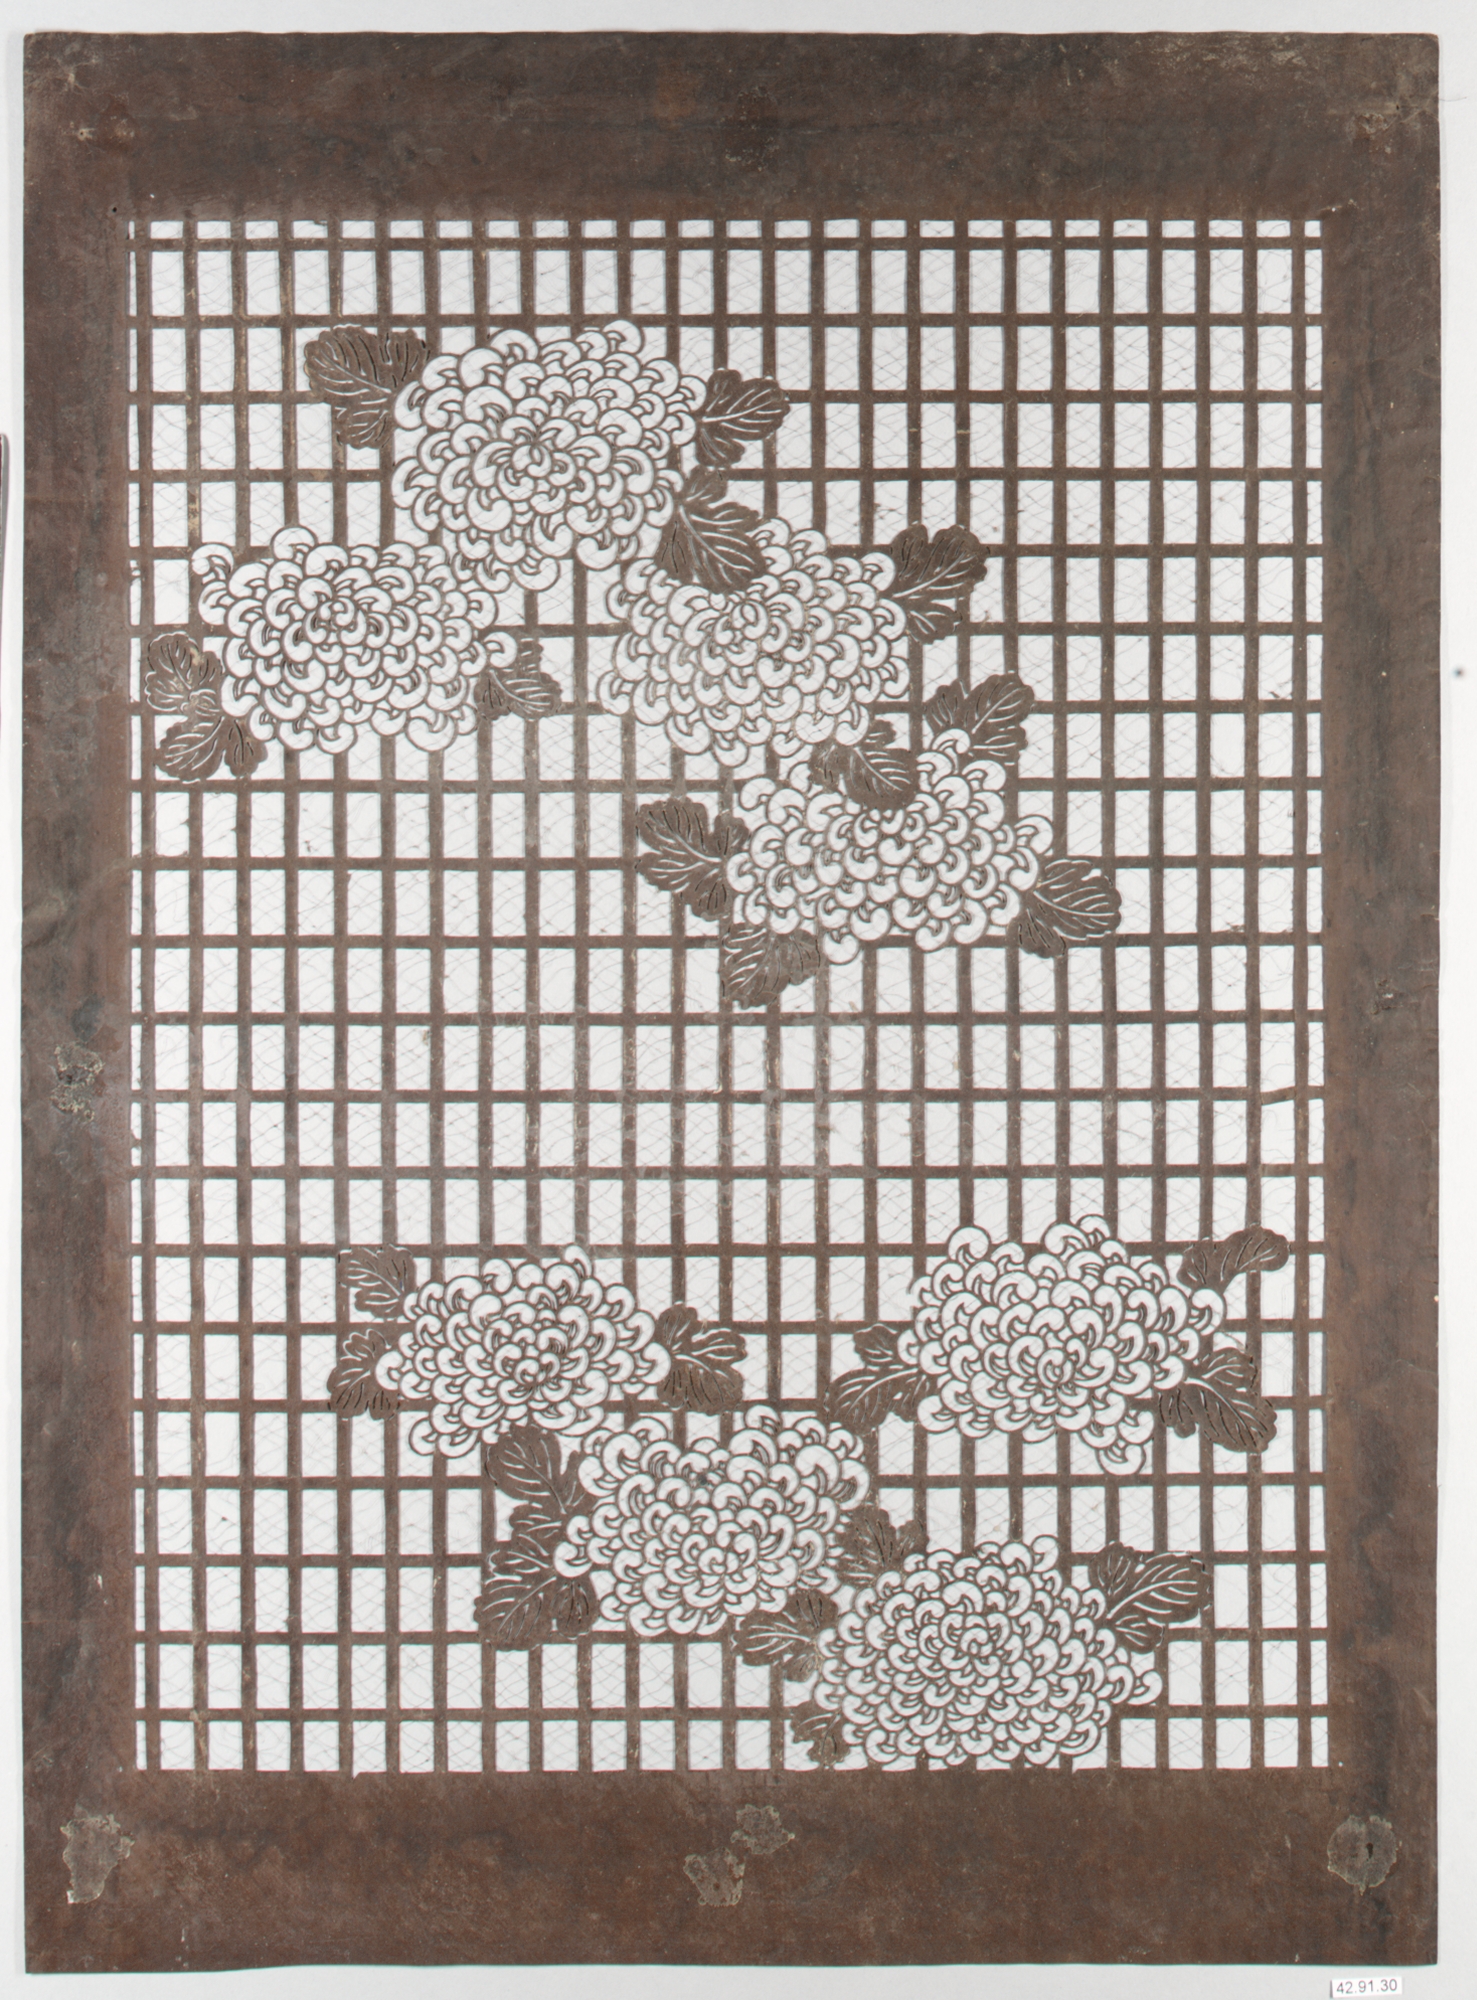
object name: stencil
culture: japanese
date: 1801-1900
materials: paper, silk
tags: flowers